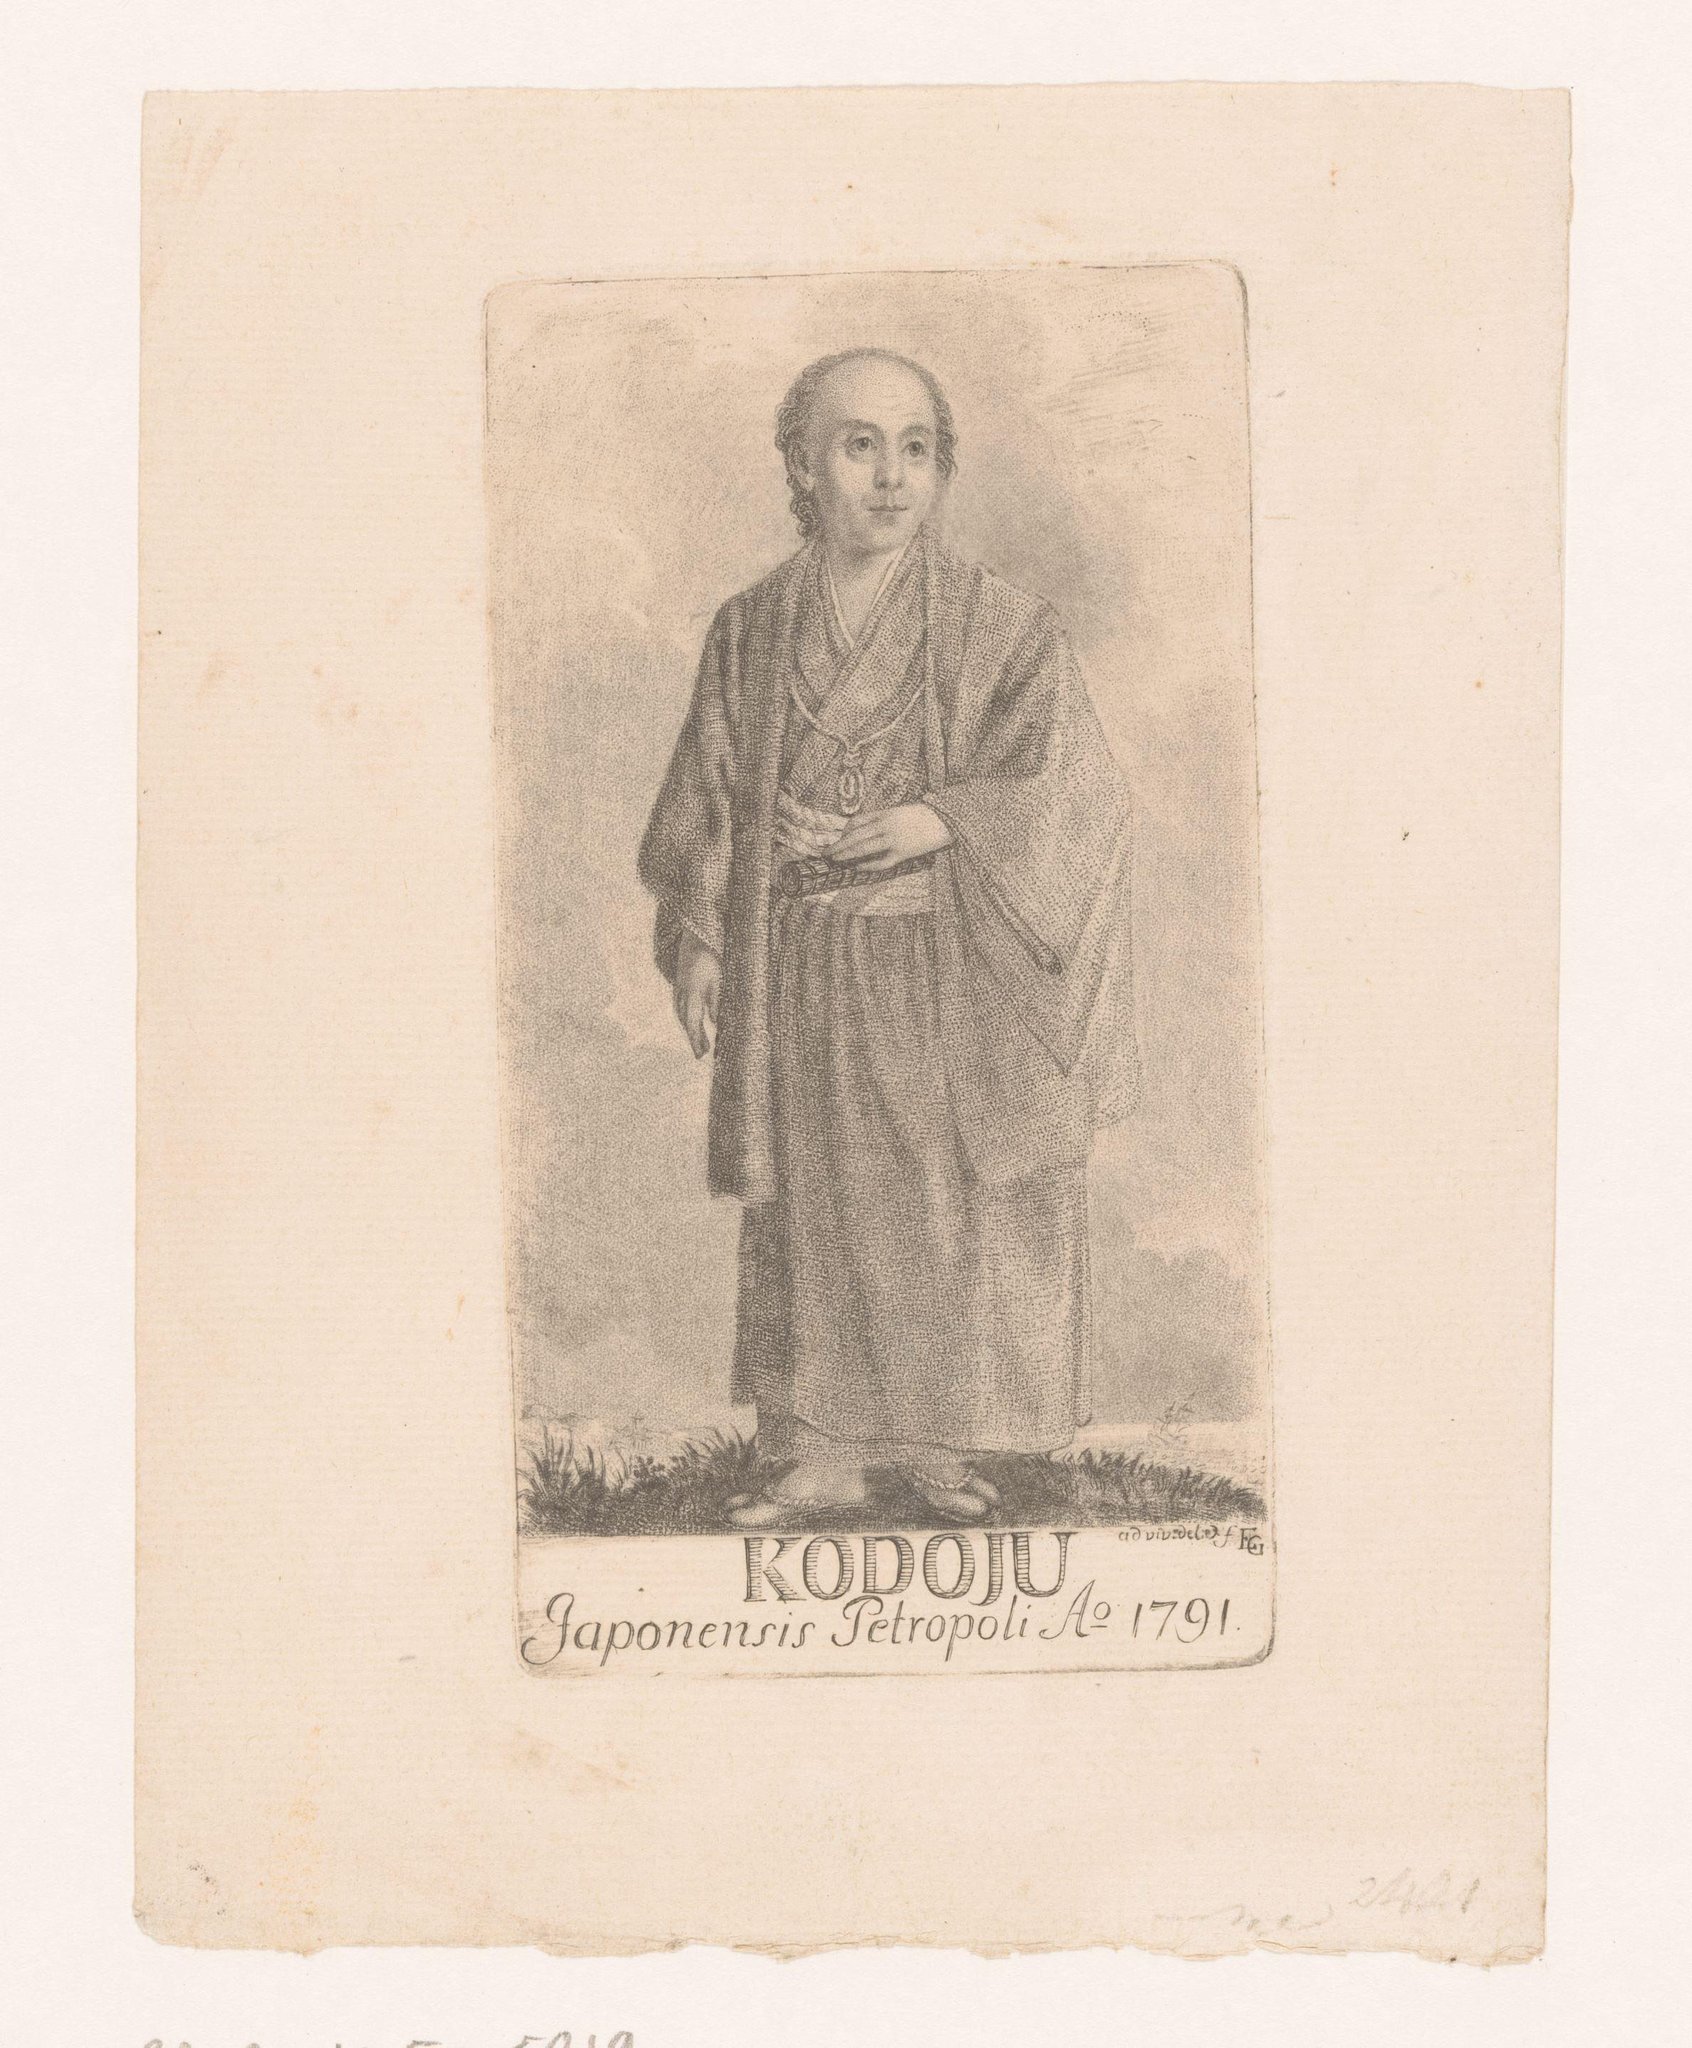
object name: print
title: Portret van Kodoju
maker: monogrammist eg (duitsland)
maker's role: print maker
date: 1791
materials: paper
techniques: engraving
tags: historical persons, japanese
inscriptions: collector's mark: Lugt 2228